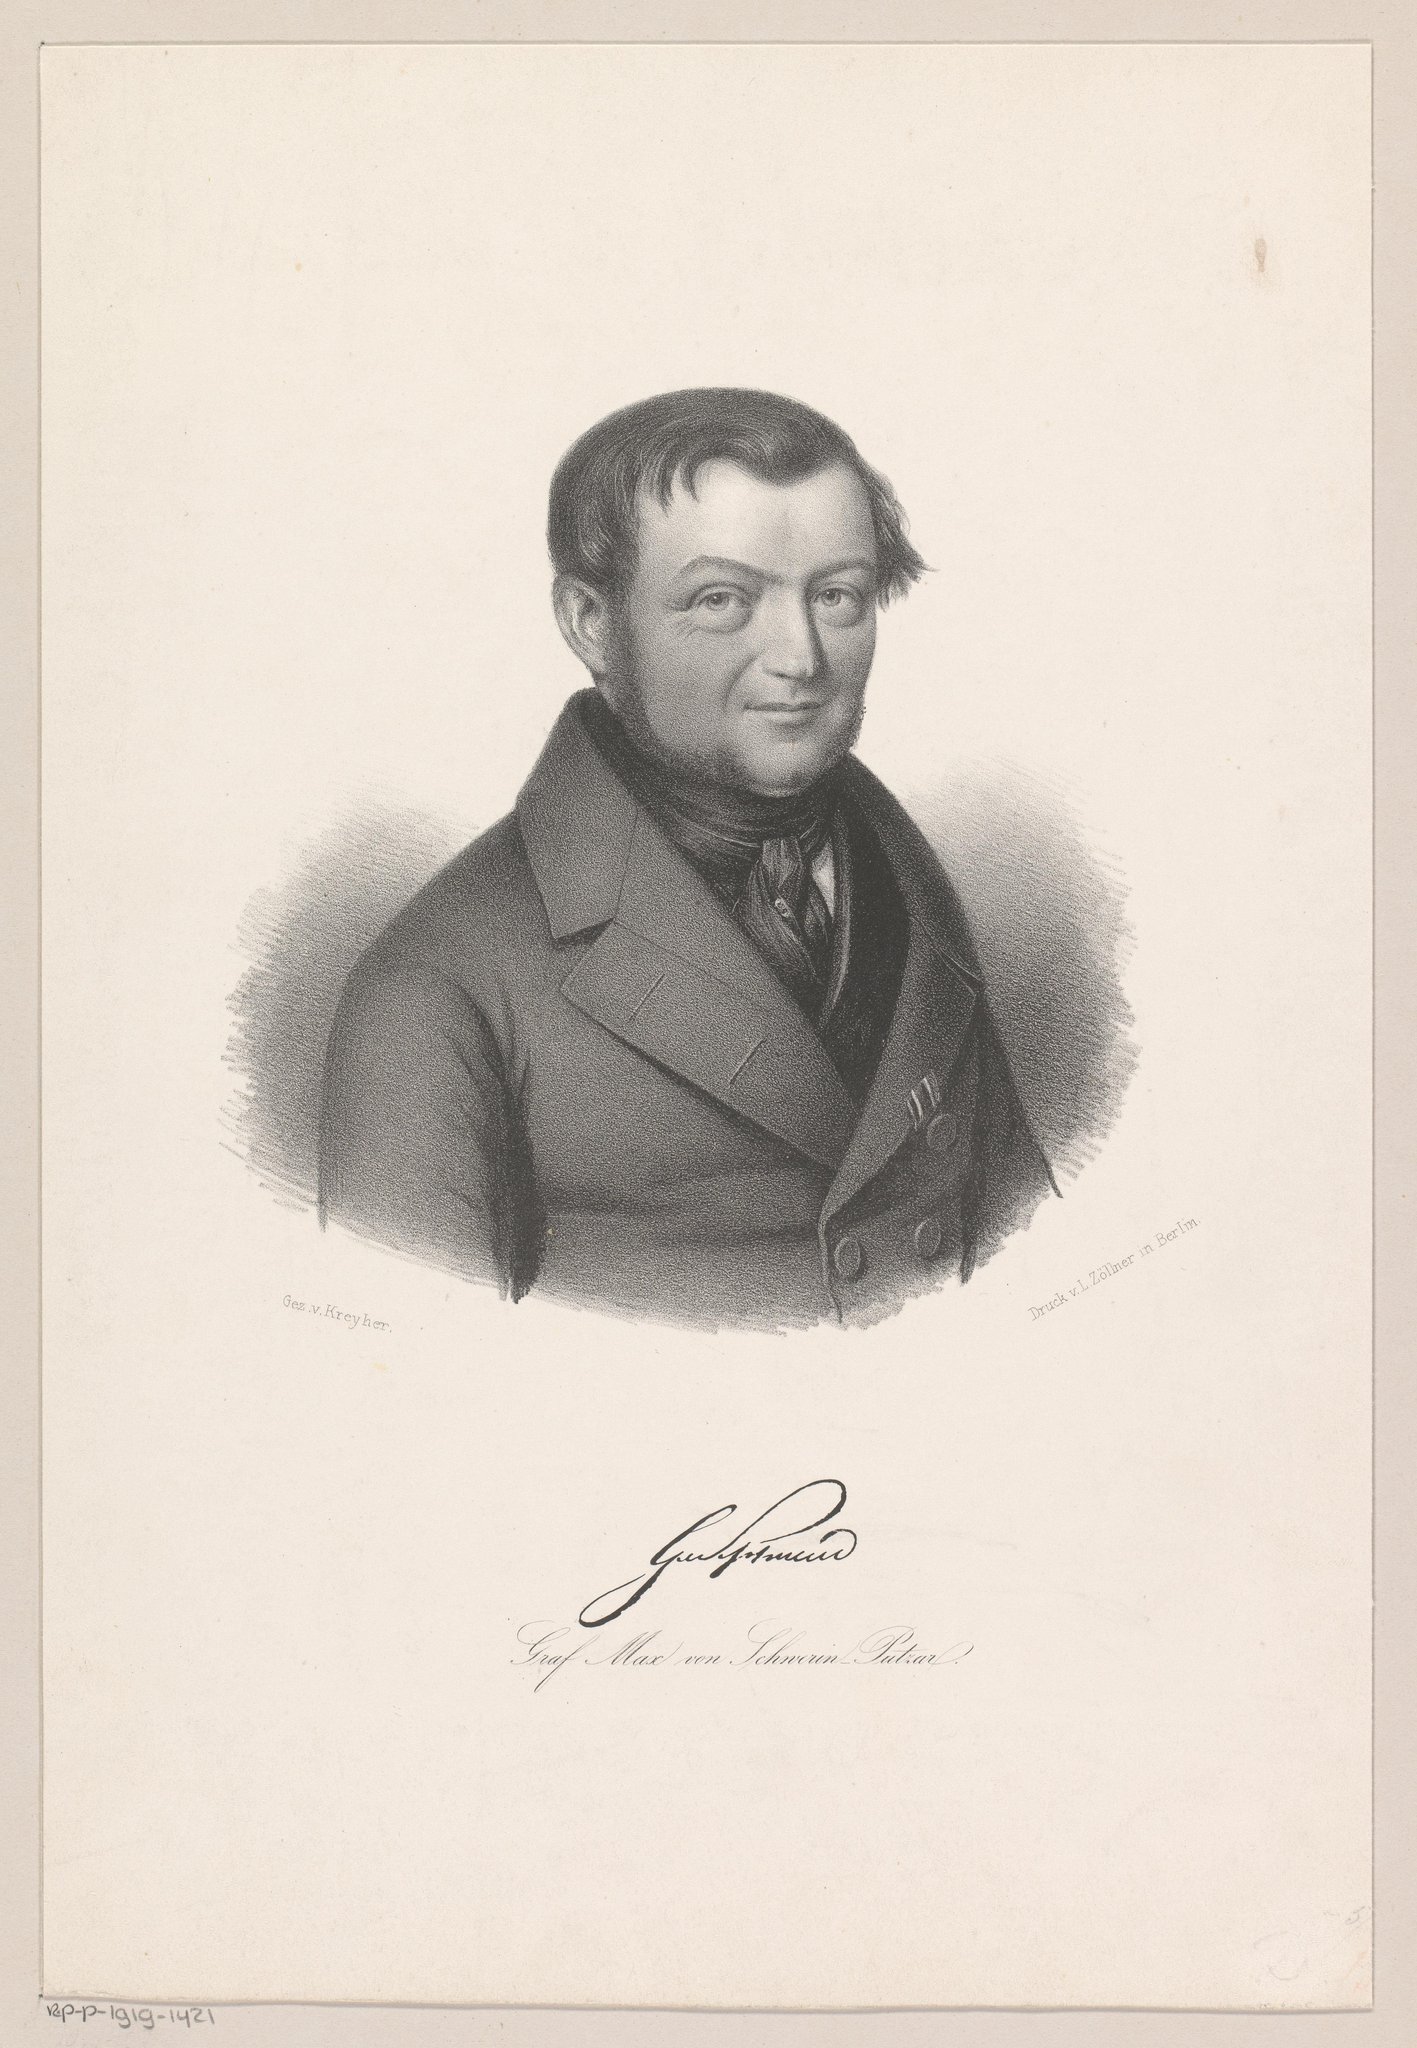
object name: print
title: Portret van Maximilian von Schwerin-Putzar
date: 1846-1905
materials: paper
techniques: lithograph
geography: berlin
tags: politician, historical persons, politician, e.g. party leader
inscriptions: collector's mark: Lugt 2228